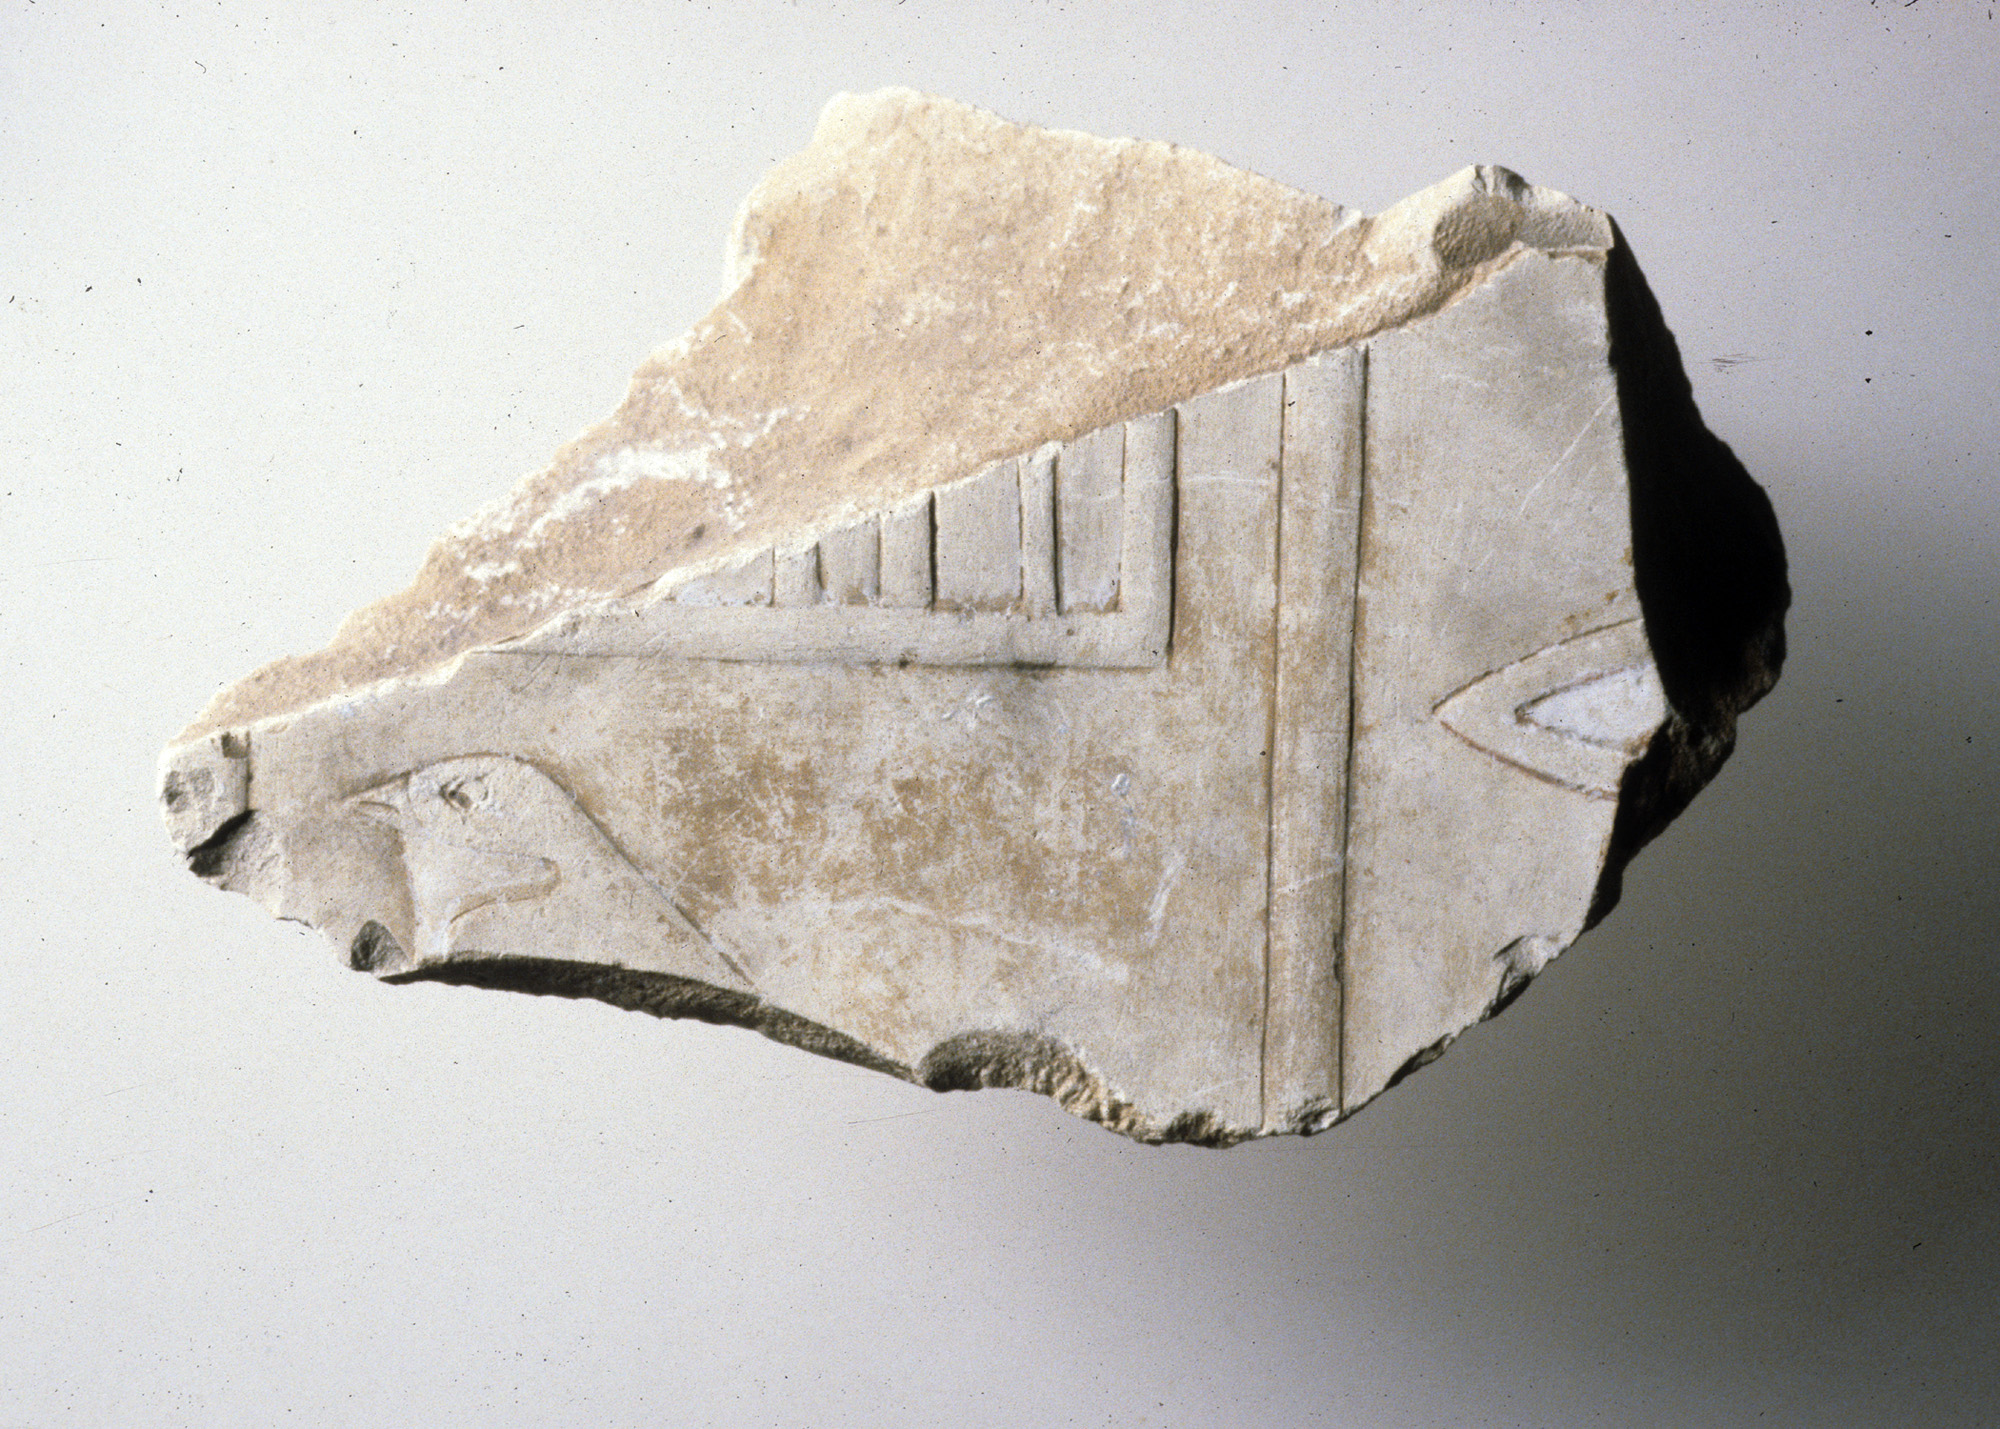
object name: relief fragment, tomb of meketre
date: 1981-1975 BCE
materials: limestone, paint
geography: egypt